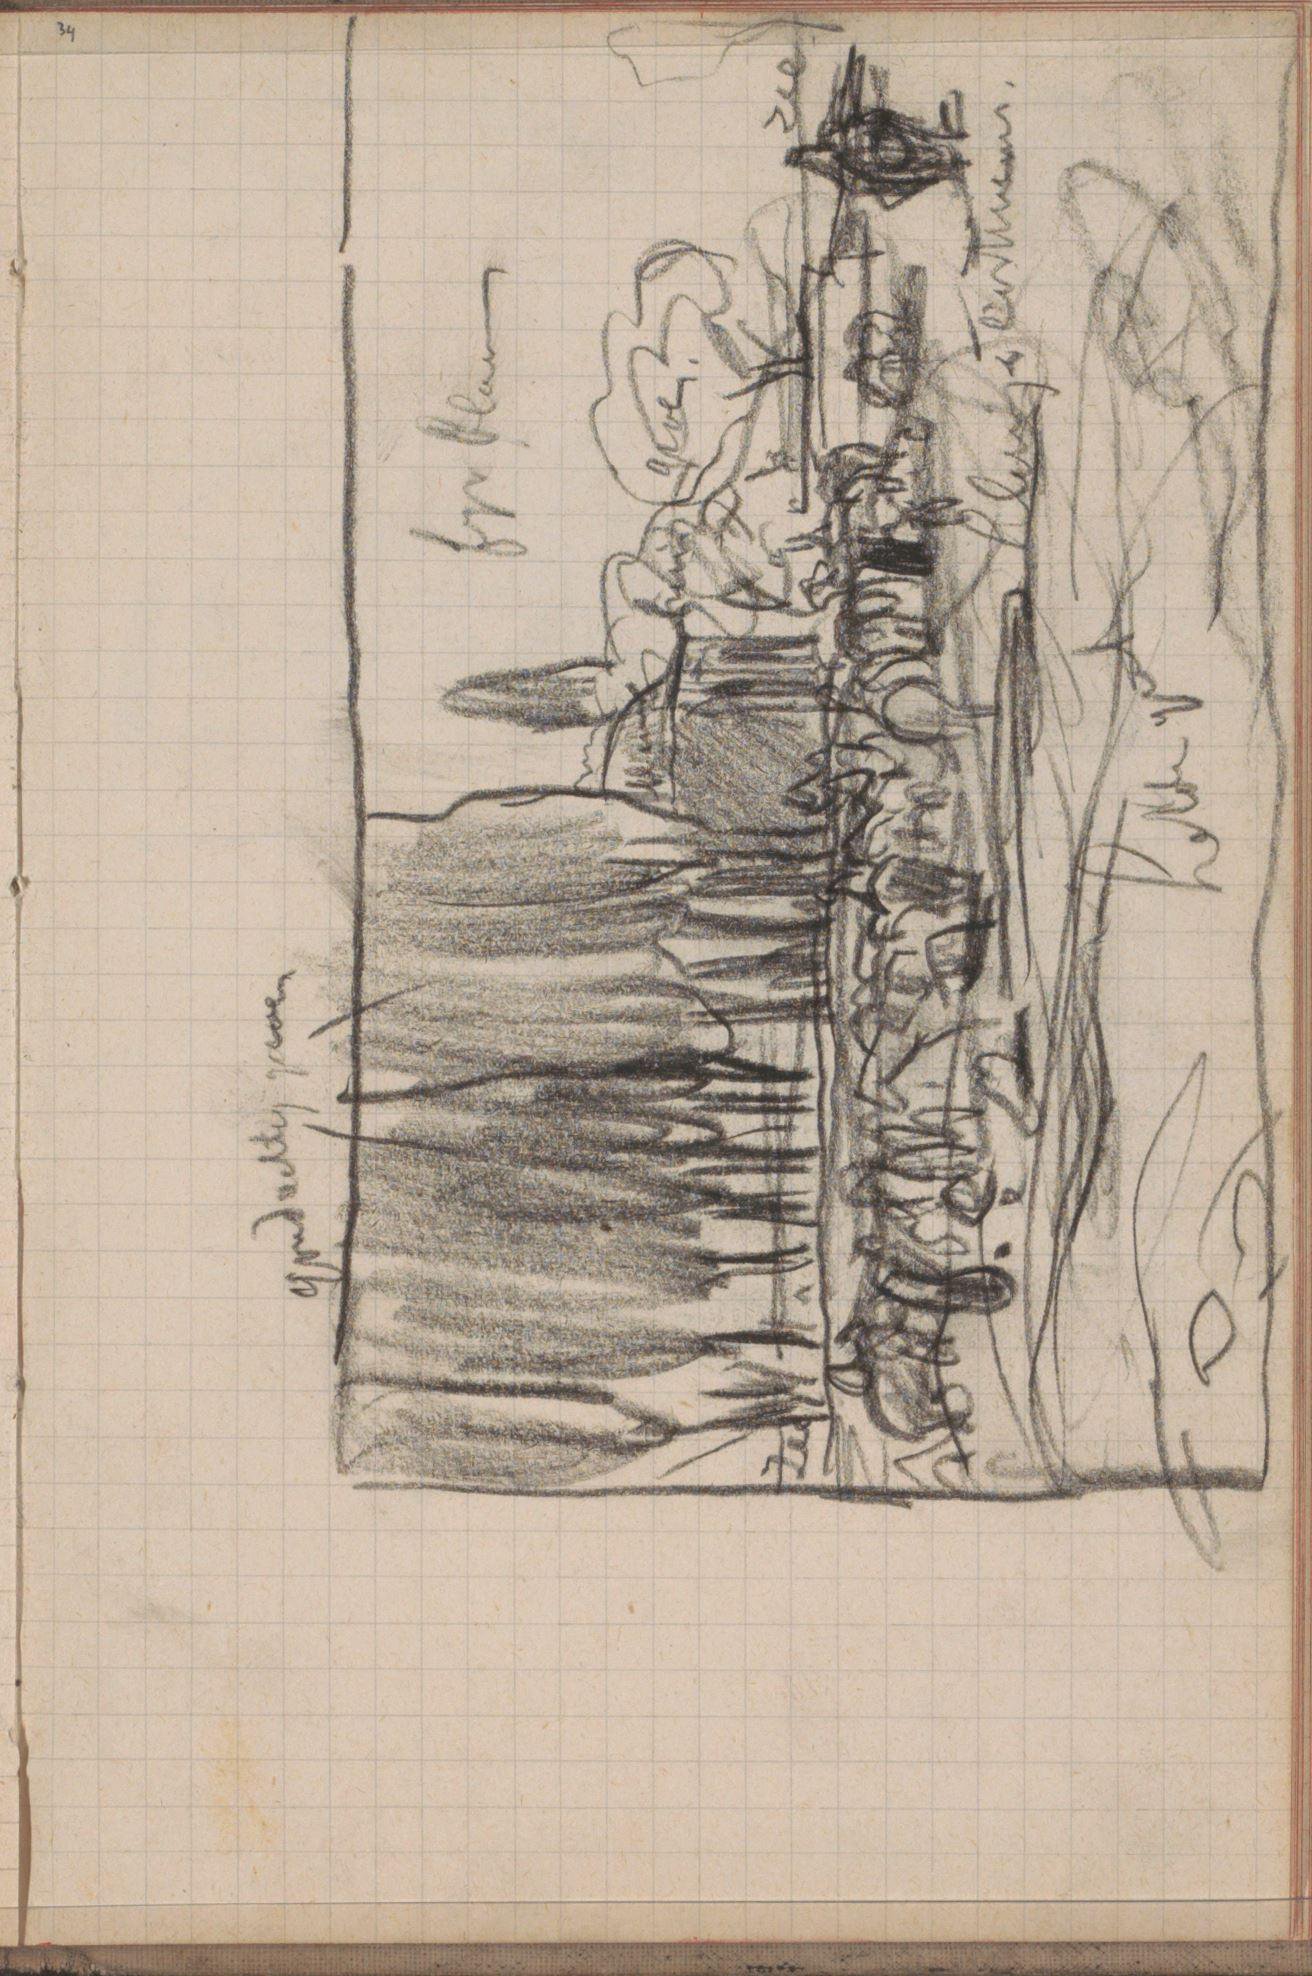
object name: sketchbook leaf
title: Landschap met bomen en vee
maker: marius bauer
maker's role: draughtsman, print maker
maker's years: 1867-1932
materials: chalk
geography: istanbul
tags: trees, landscapes, cattle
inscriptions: kleurnotitie, handgeschreven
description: Pagina 34 uit een schetsboek met 54 bladen.